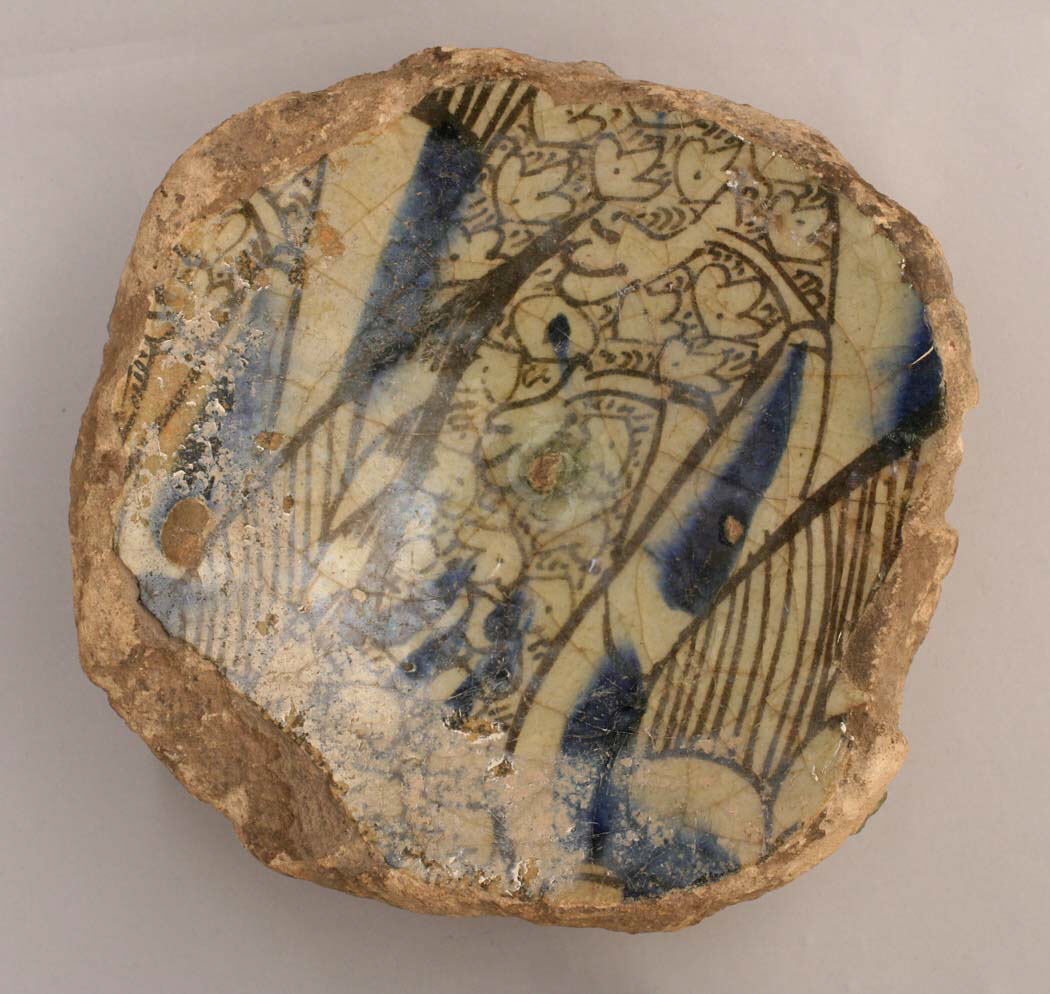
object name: ceramic fragment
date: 1301-1400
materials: glaze, stonepaste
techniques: painting, polychrome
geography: egypt